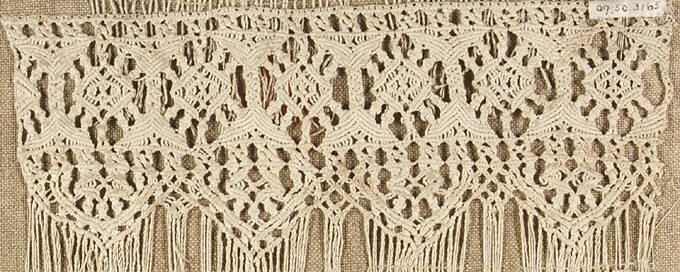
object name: fragment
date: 1601-1800